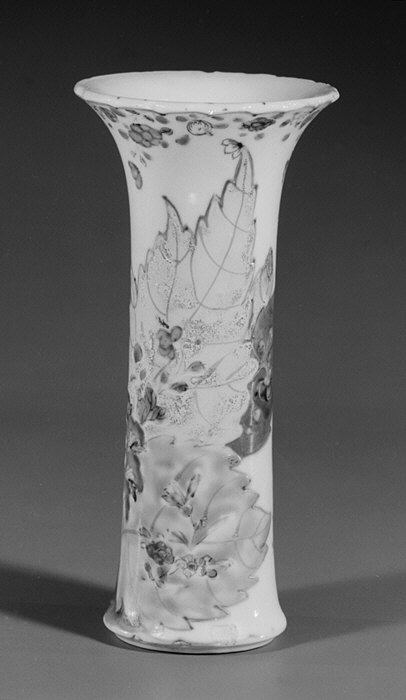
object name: vase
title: Miniature vase (one of a pair)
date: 1767-1833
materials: hard paste porcelain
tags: flowers